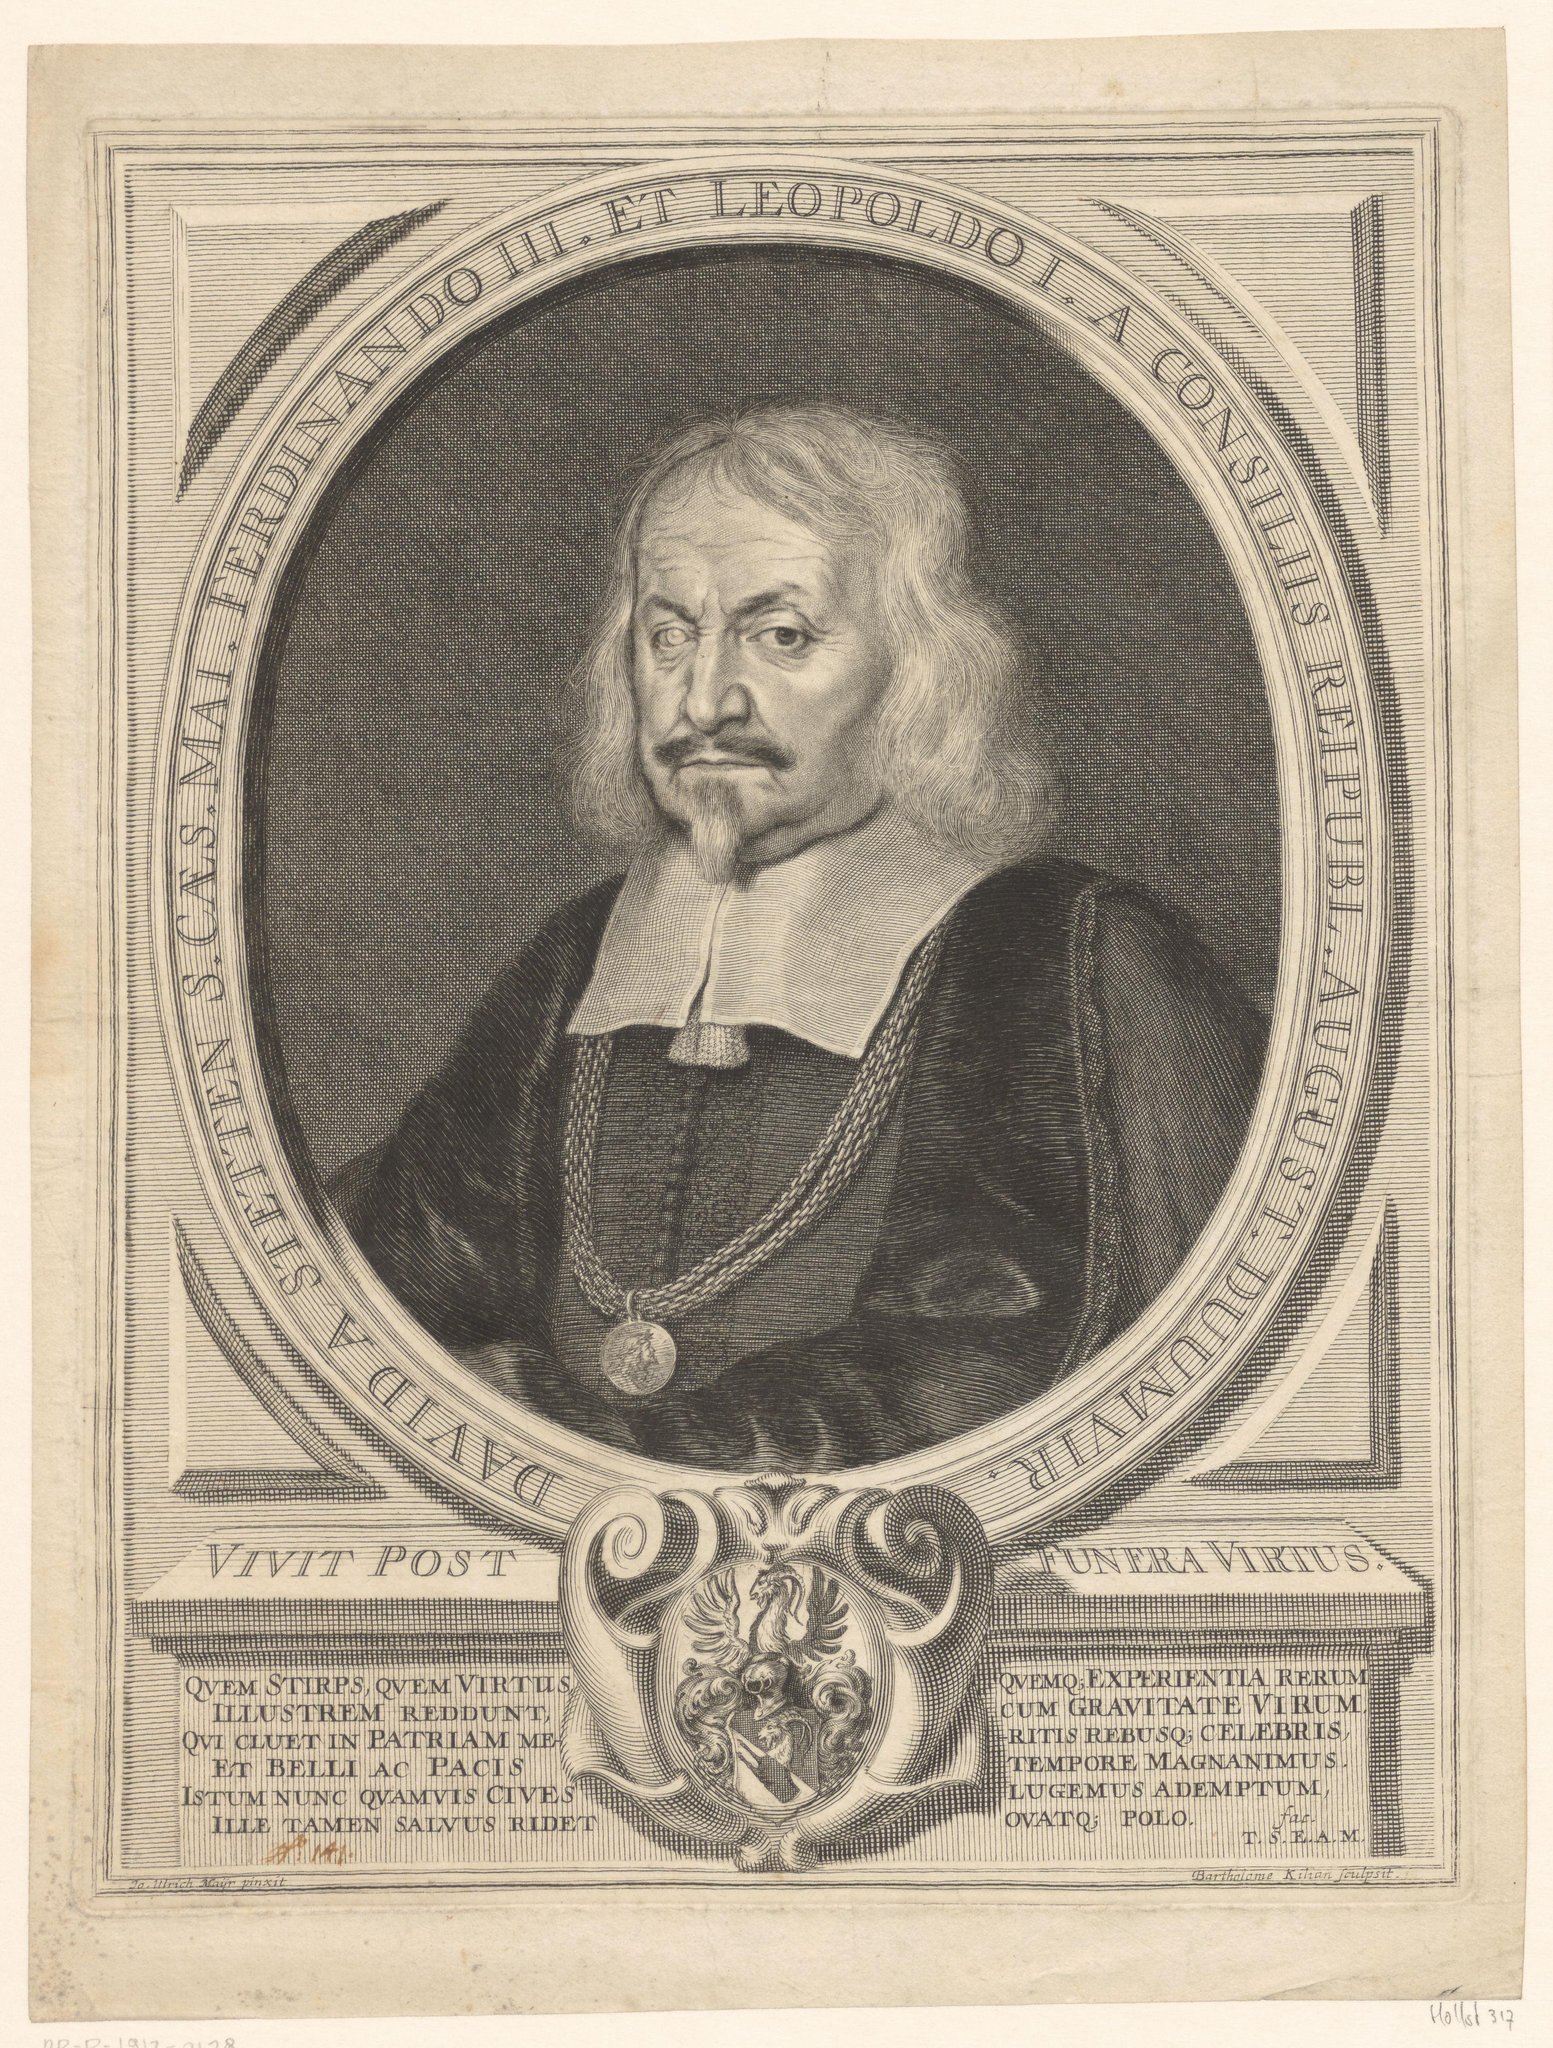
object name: print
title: Portret van David von Stetten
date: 1653-1696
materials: paper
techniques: engraving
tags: mayor, mayor, burgomaster, historical persons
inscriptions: collector's mark: Lugt 2228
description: Tekst in het Latijn in de omlijsting en op de sokkel.